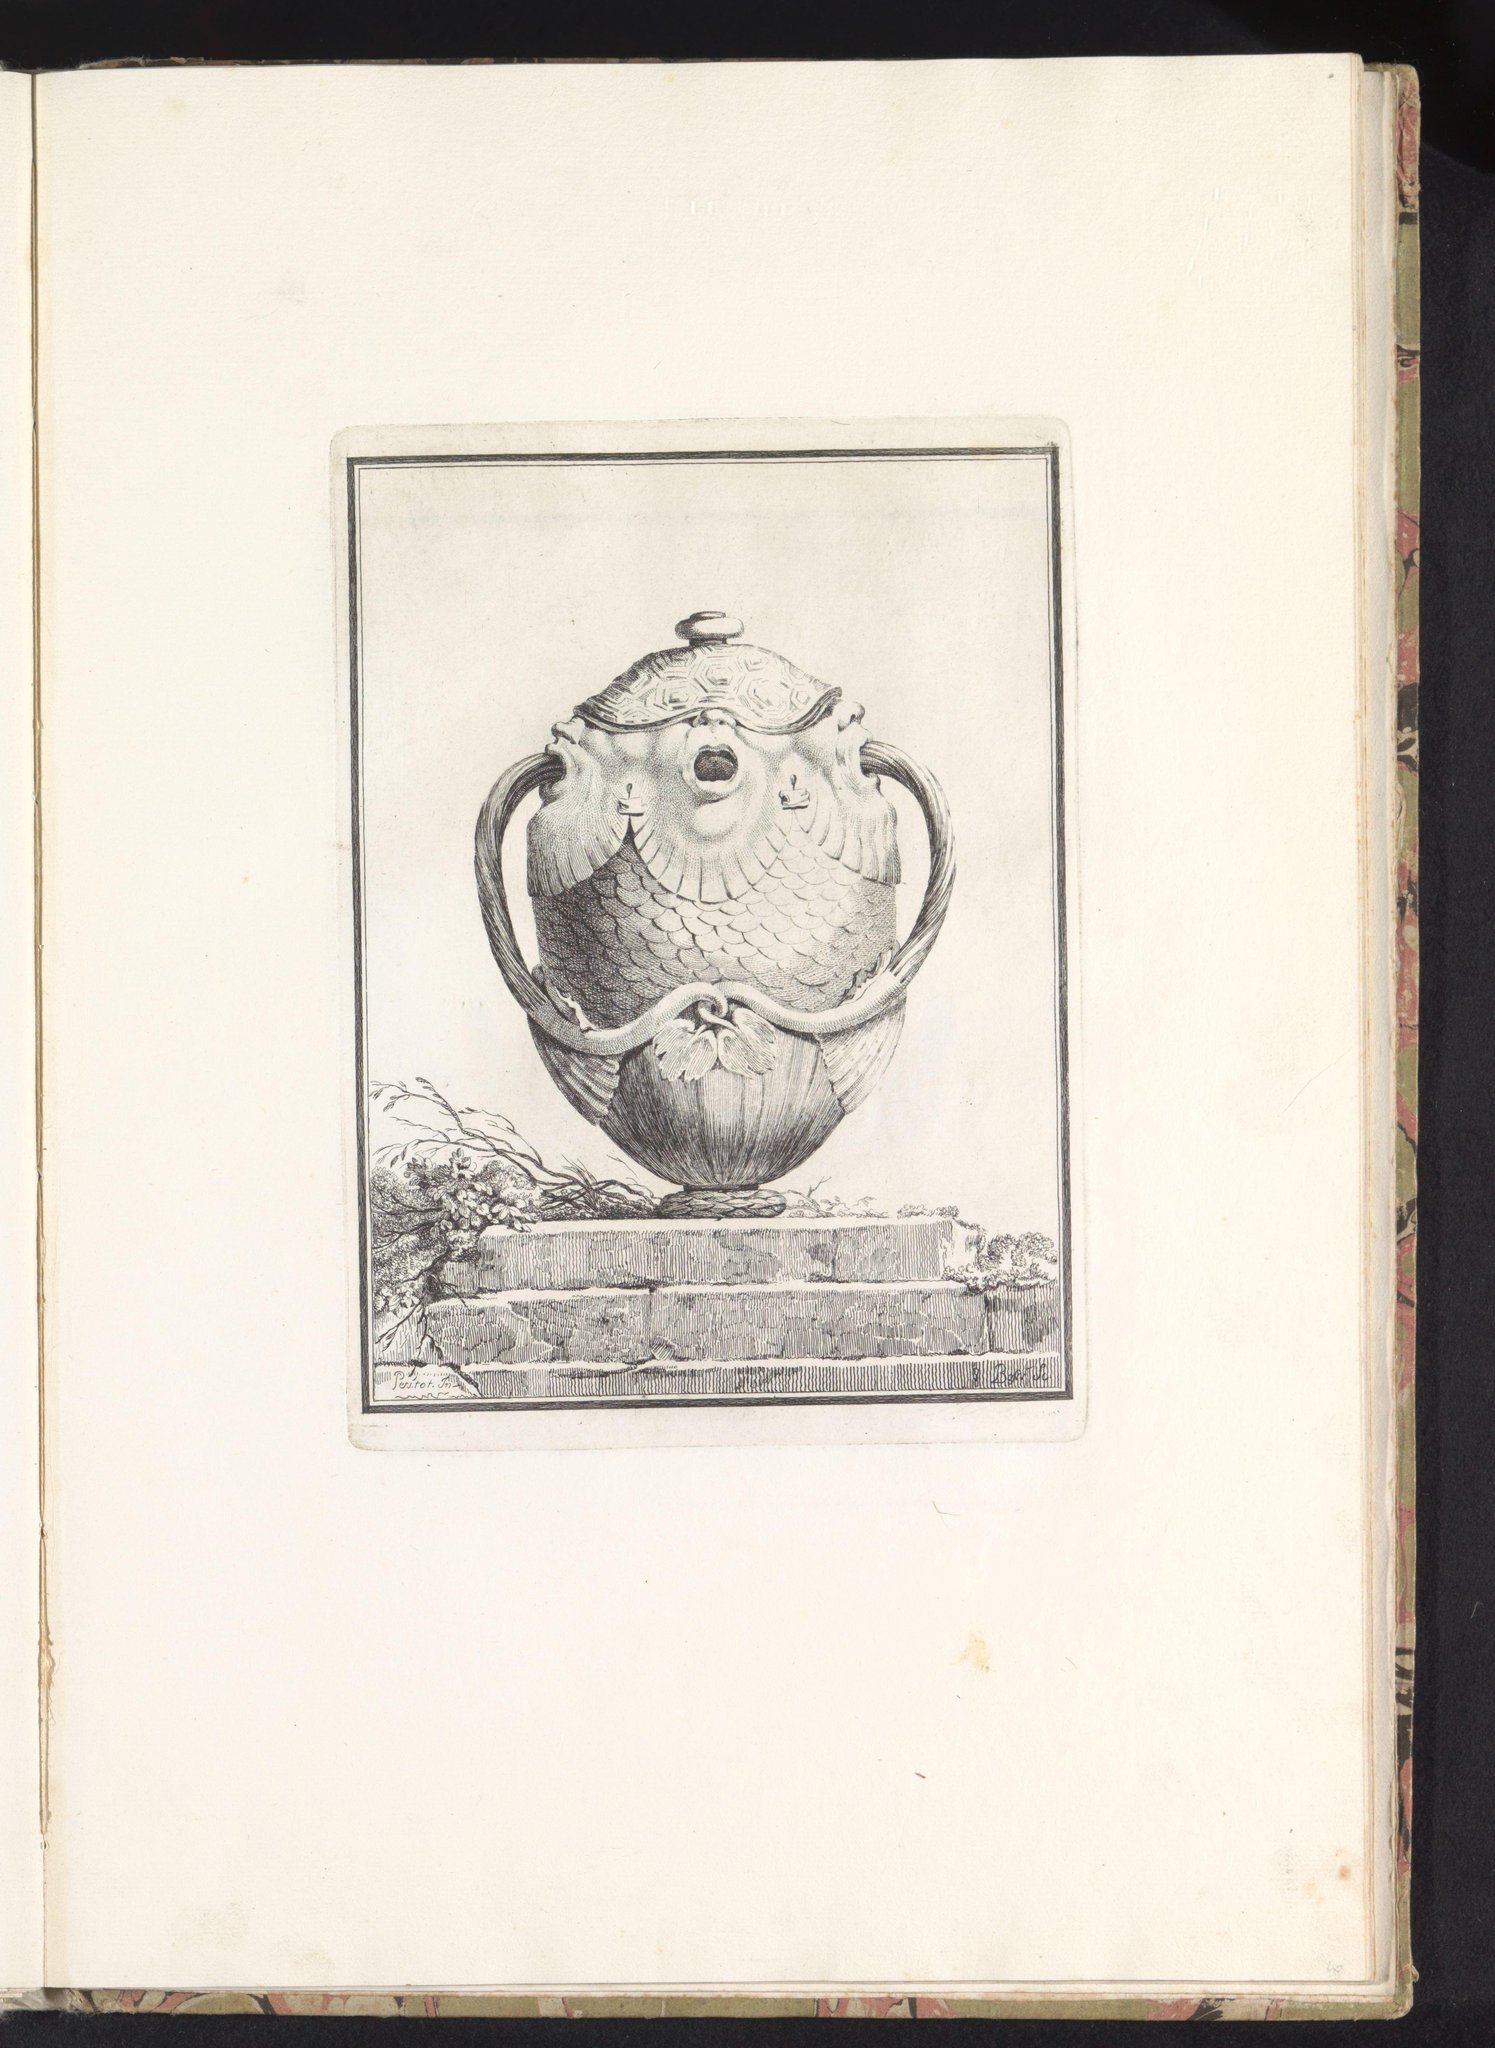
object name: album leaf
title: Pot met deksel, gedecoreerd met maskarons met open monden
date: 1764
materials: paper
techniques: etching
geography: parma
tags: vase ~ ornament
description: Eivormige geschubde pot met deksel. De oren worden gevormd door twee slangen. Maskarons met open monden decoreren de bovenkant van de pot; het deksel valt half over de ogen. De pot staat op een muur waaroverheen onkruid groeit. No. 11 uit serie van 31. Prent maakt deel uit van een album. Gedrukt recto rechtsboven: 11.